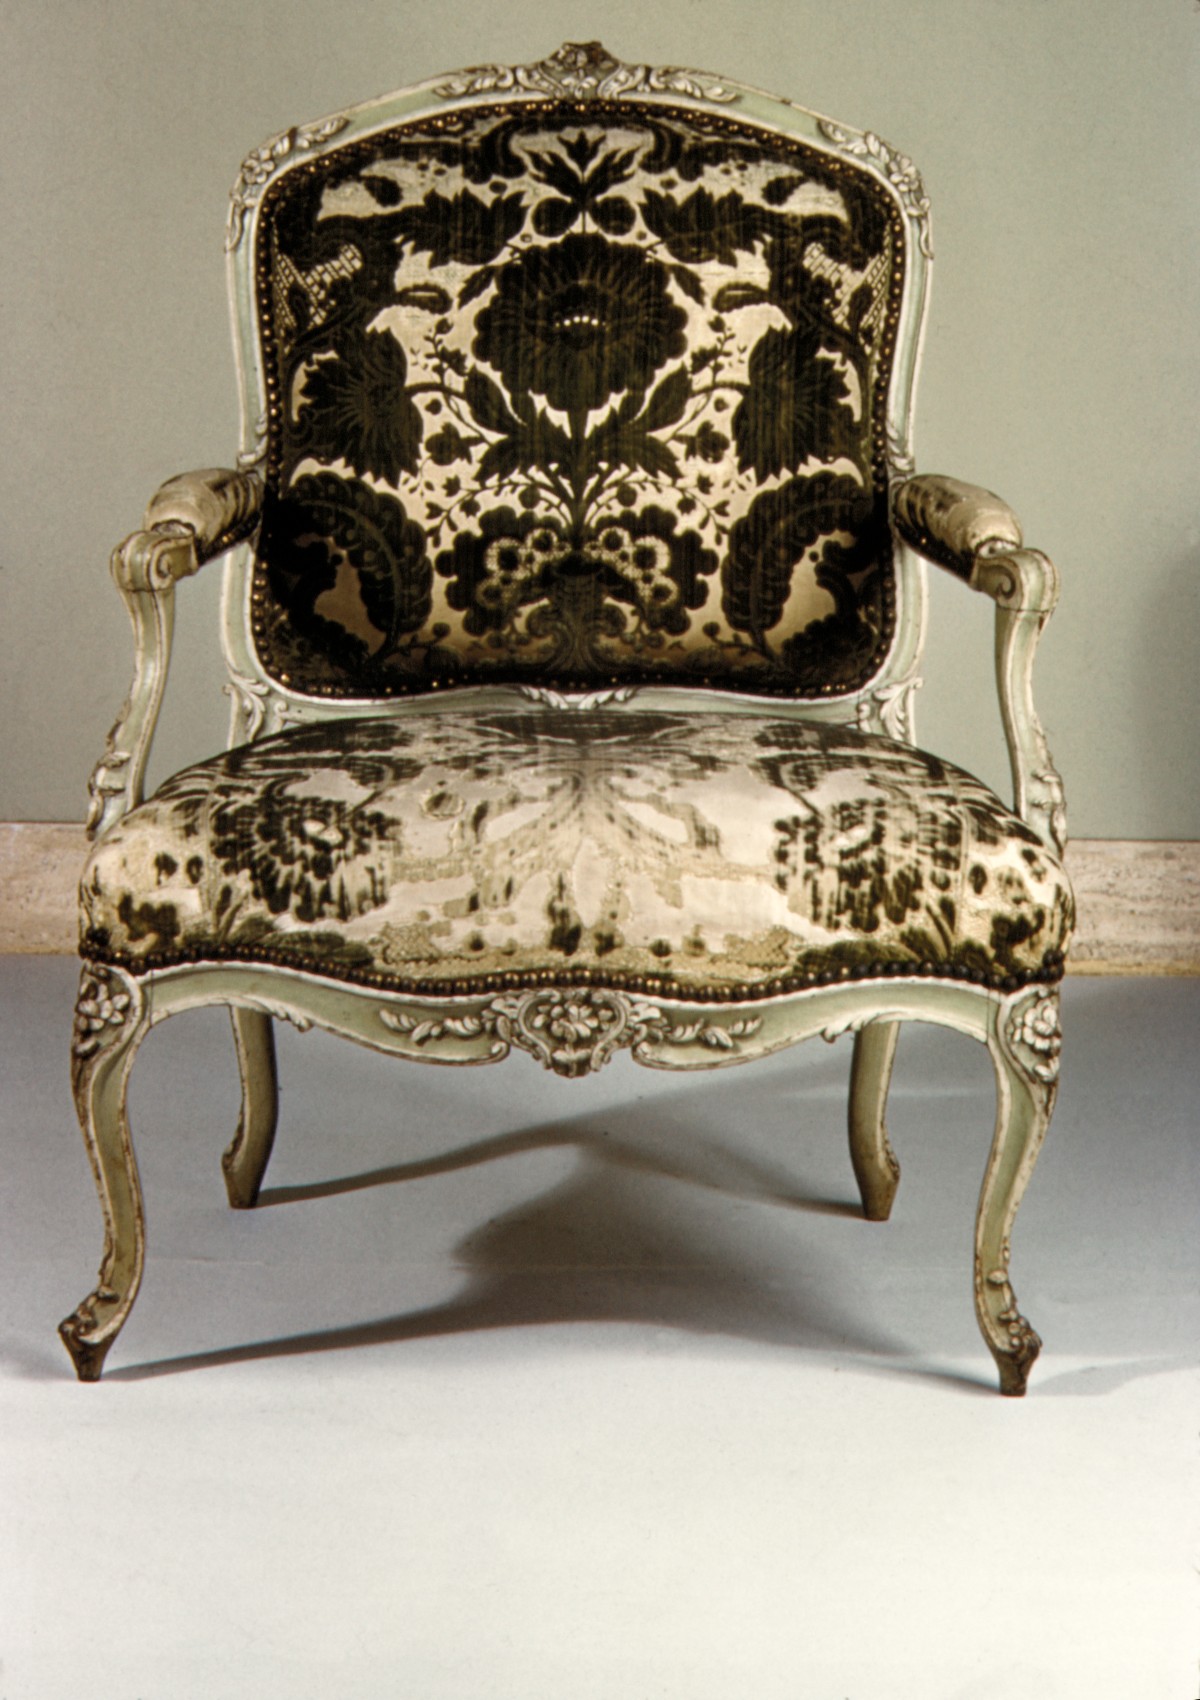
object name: armchair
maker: michel gourdin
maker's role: maker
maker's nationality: french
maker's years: 1677-1777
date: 1760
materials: wood, velvet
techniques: carving, cutting, painting, voiding